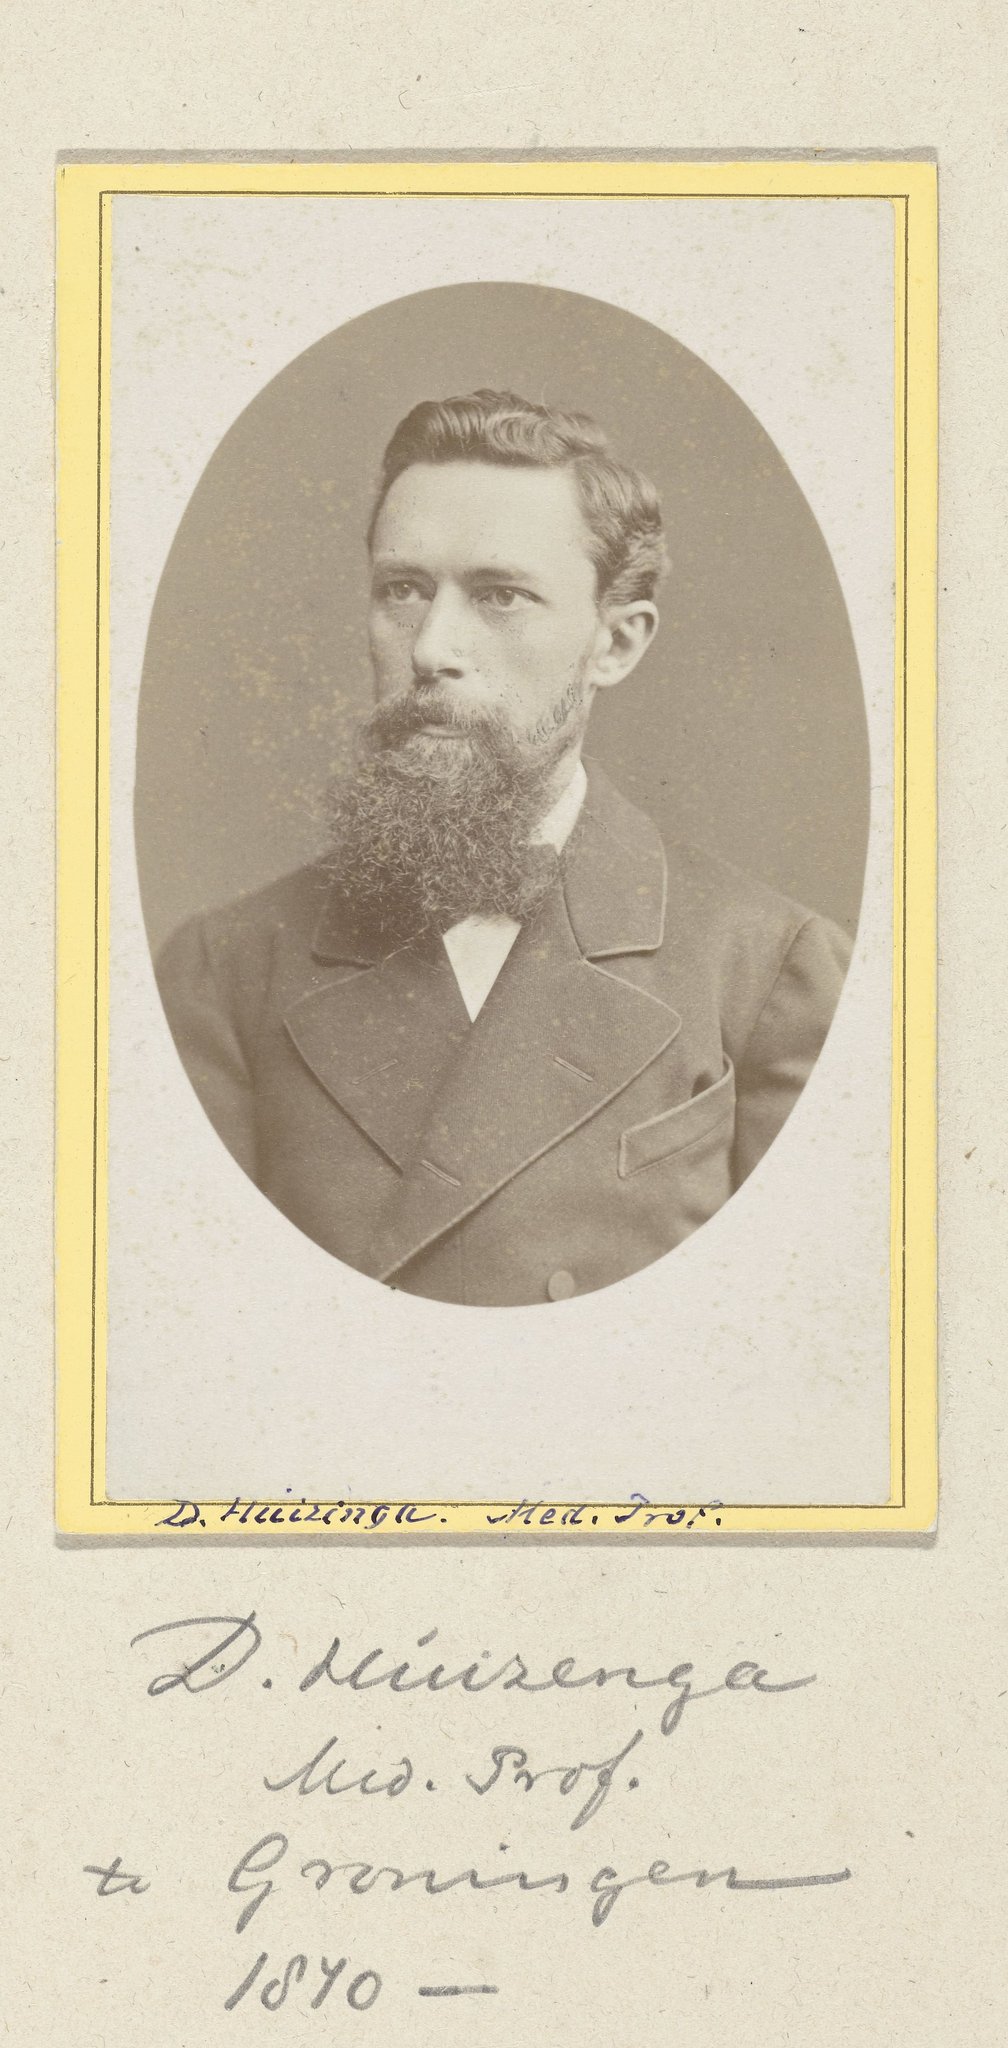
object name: carte de visite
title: Portret van professor D. Huizinga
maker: Anonymous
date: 1860-1880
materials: paper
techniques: albumen print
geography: netherlands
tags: historical persons (portraits and scenes from the life)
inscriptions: name: ‘D. Huizinga, med. prof. te Groningen 1870 -’